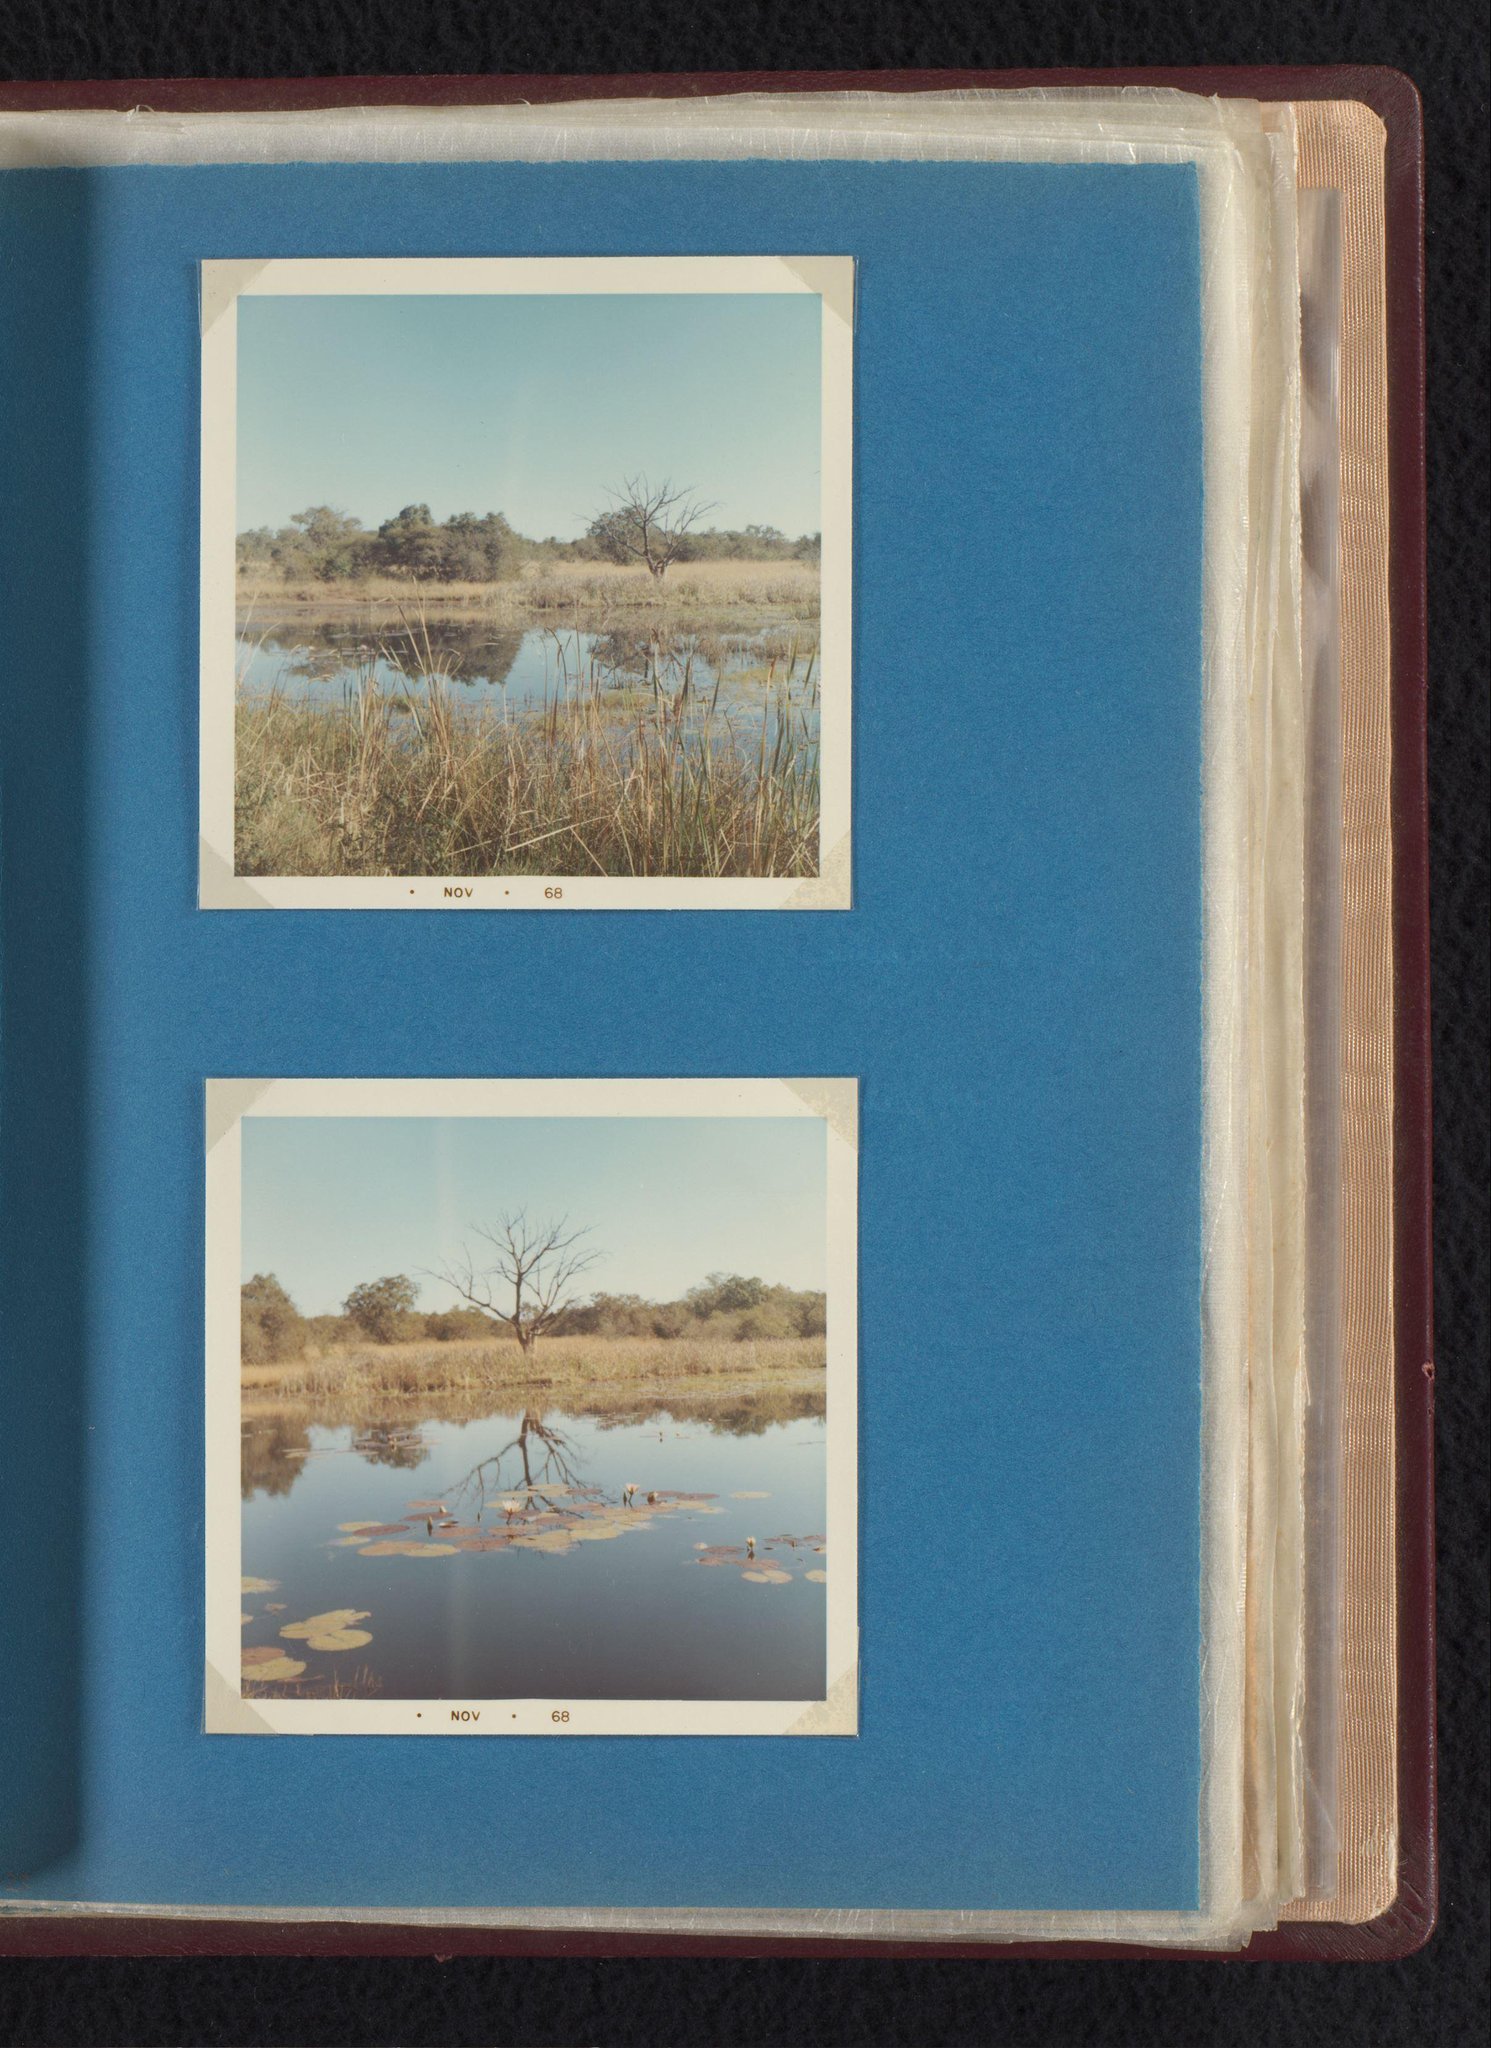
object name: photograph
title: Waterlelies bij Shewasaulu, Zuid-Afrika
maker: willem jacob van den berg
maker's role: boer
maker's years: 1902-1983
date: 1911-1968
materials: paper, cardboard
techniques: chromogenic print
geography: shewasaulu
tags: flowers: water-lily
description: Deze foto's zijn onderdeel van een album.